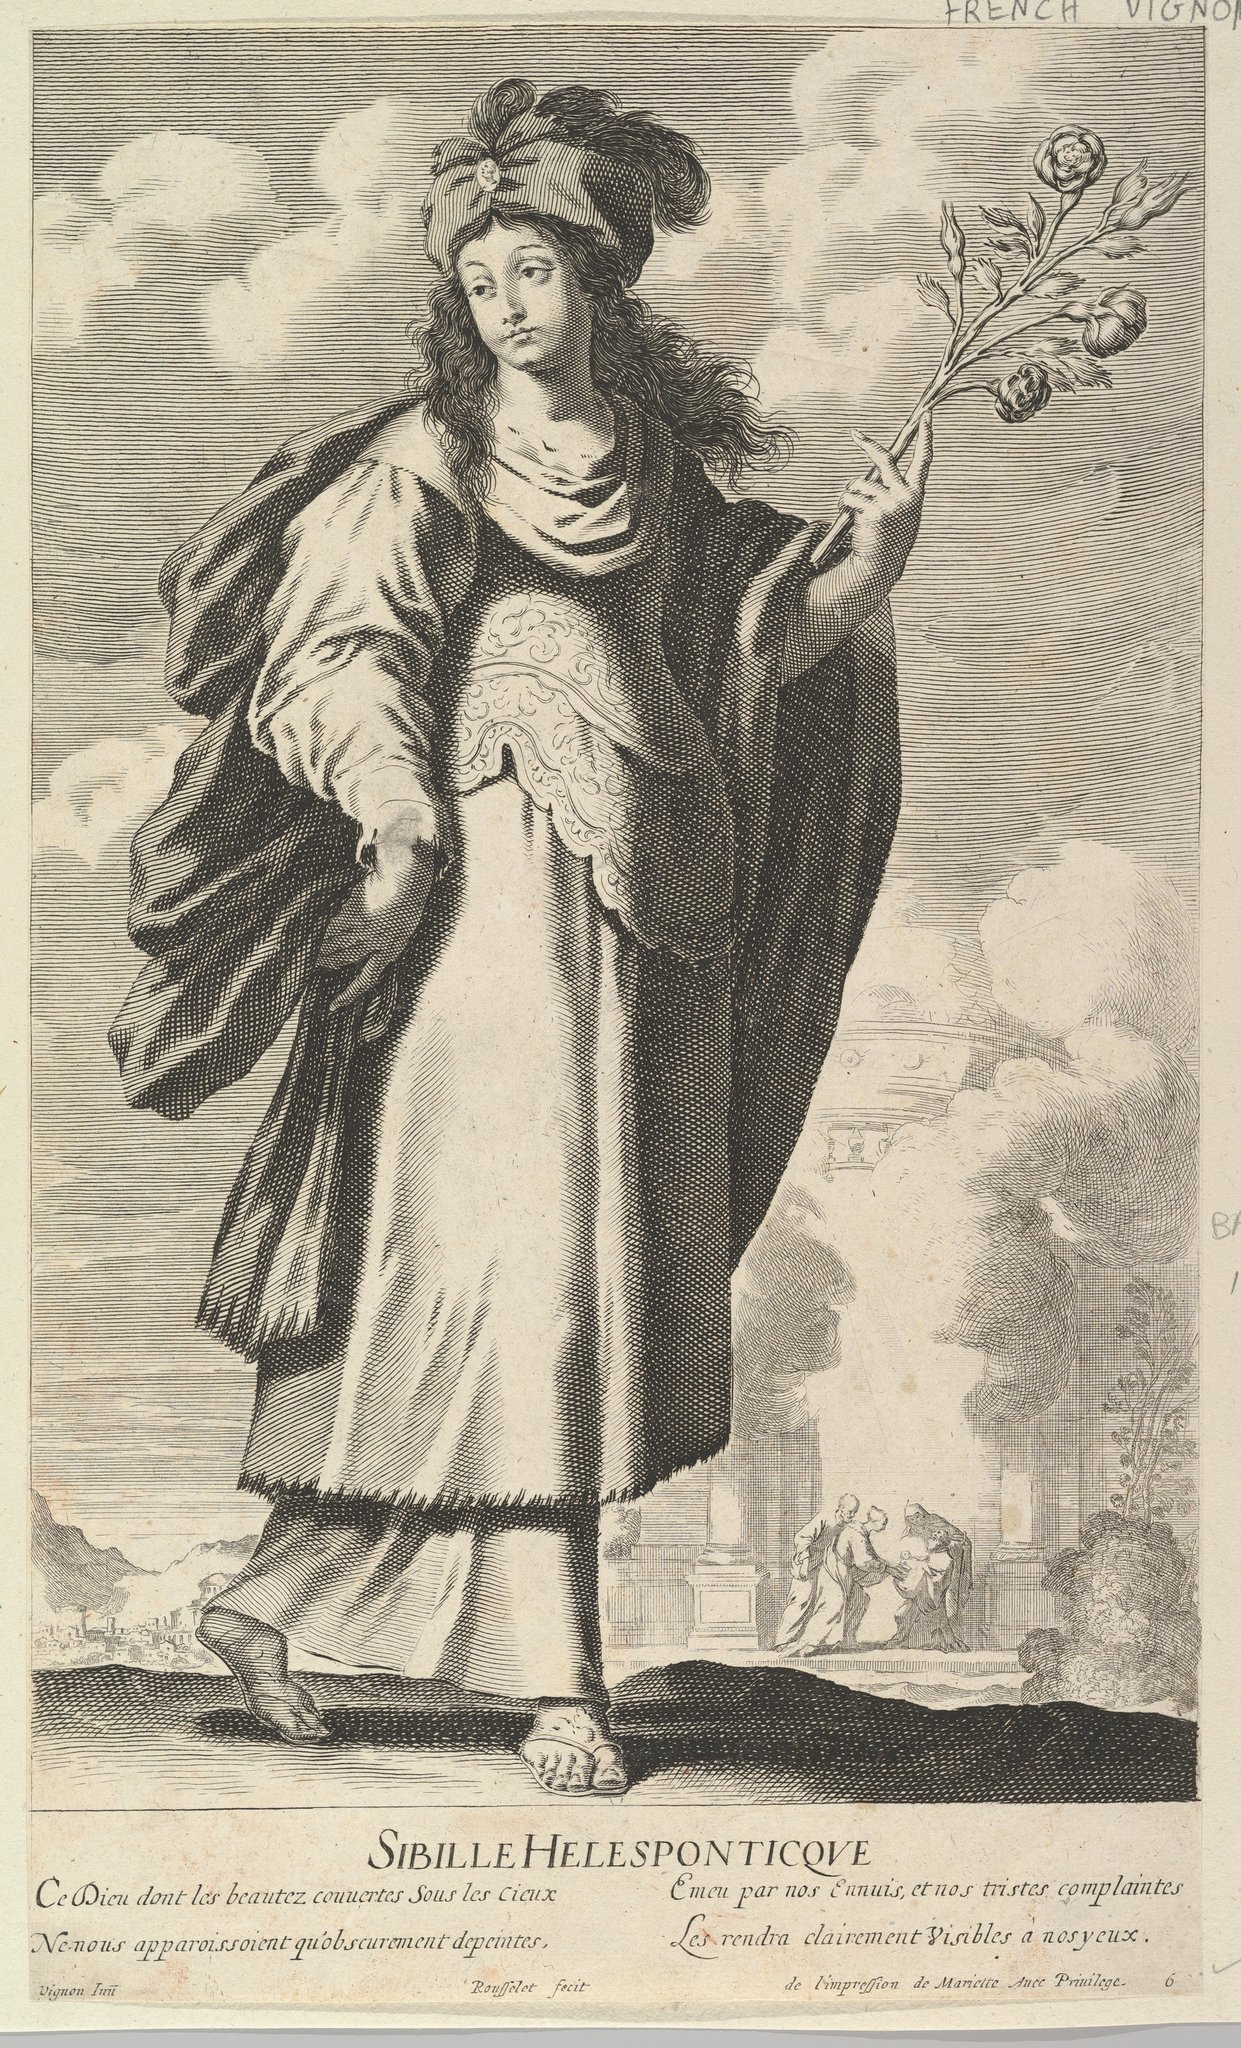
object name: print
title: Sibylle Hellespontique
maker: gilles rousselet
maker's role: artist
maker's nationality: french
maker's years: 1614-1686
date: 1635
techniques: engraving, etching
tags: sibyl,flowers